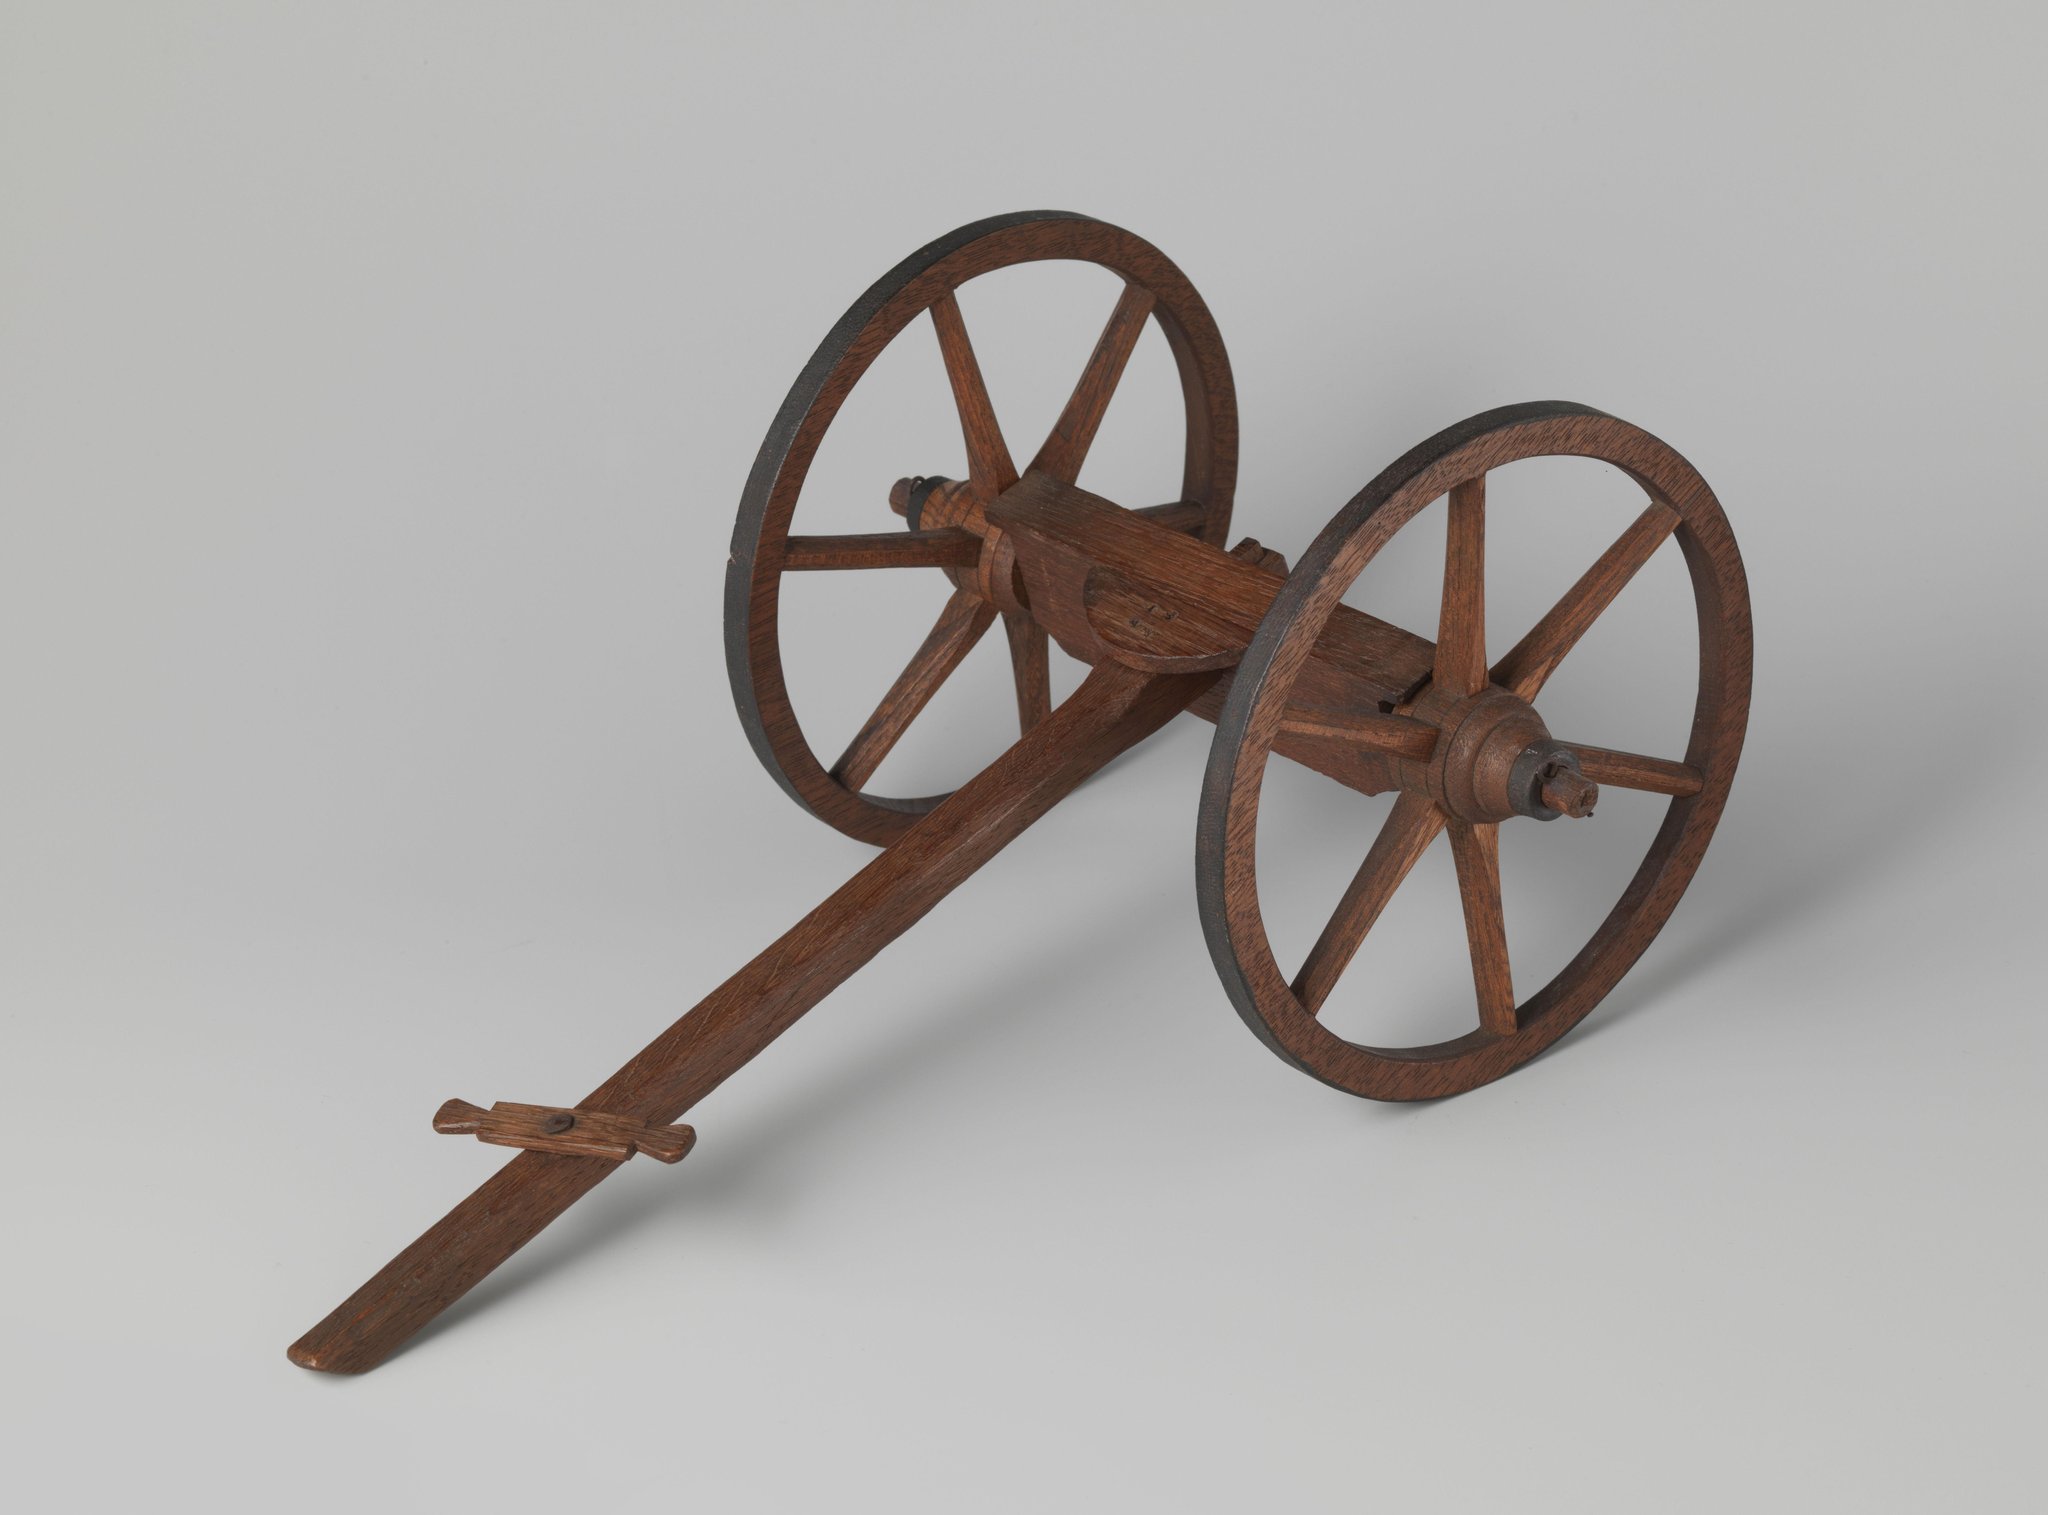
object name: scale model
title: Model van een wagen (mallejan) met plankje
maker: h. essen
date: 1845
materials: wood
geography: northern netherlands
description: Model van een wagen (mallejan) met plankje.